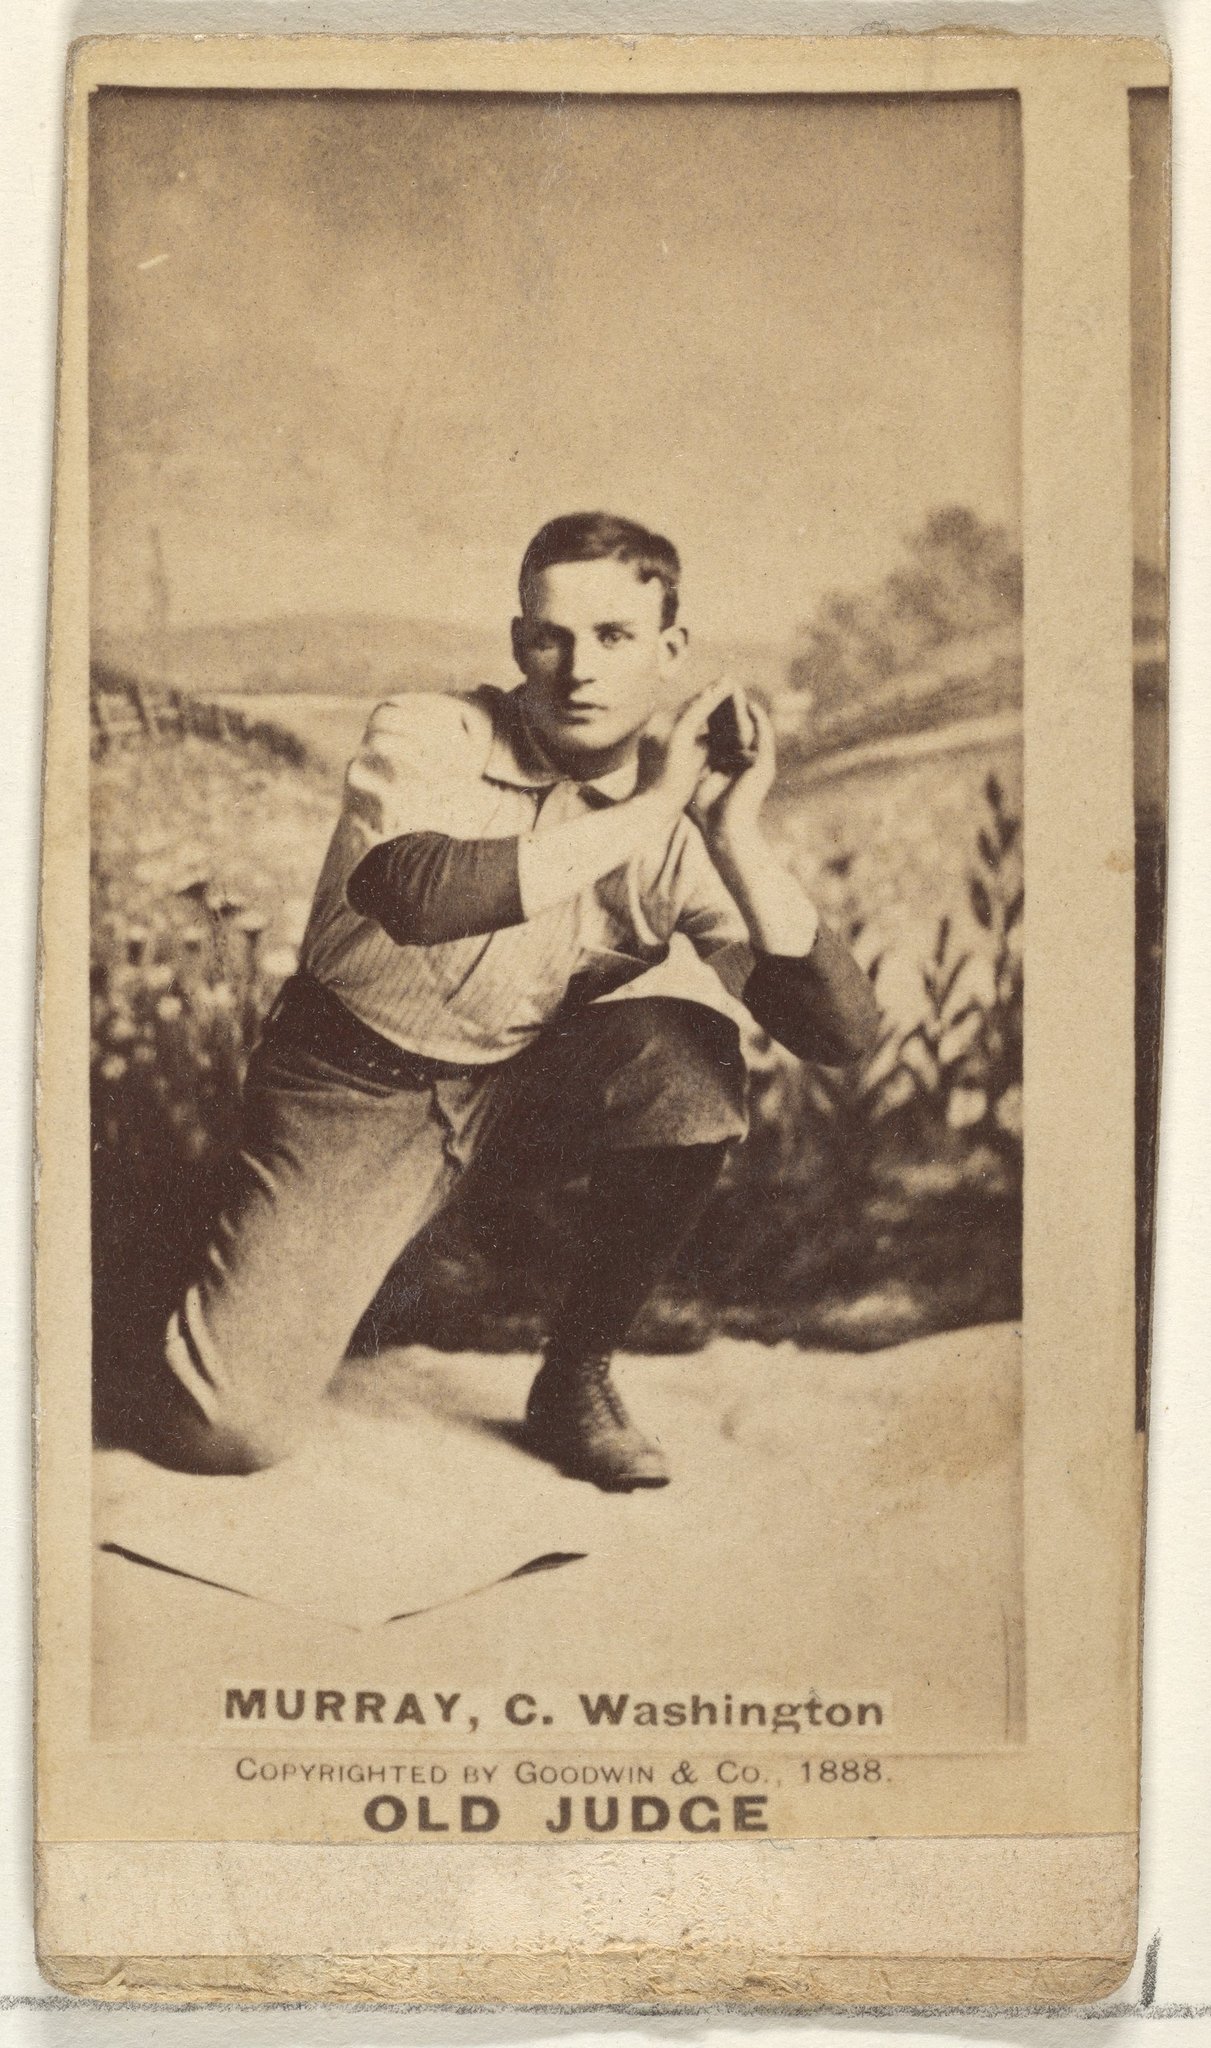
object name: baseball card, photograph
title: Jeremiah J. "Miah" Murray, Catcher, Washington Nationals, from the Old Judge series (N172) for Old Judge Cigarettes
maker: goodwin & company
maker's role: publisher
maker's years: 1850-1950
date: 1888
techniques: albumen silver print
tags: men,portraits,baseball,athletes